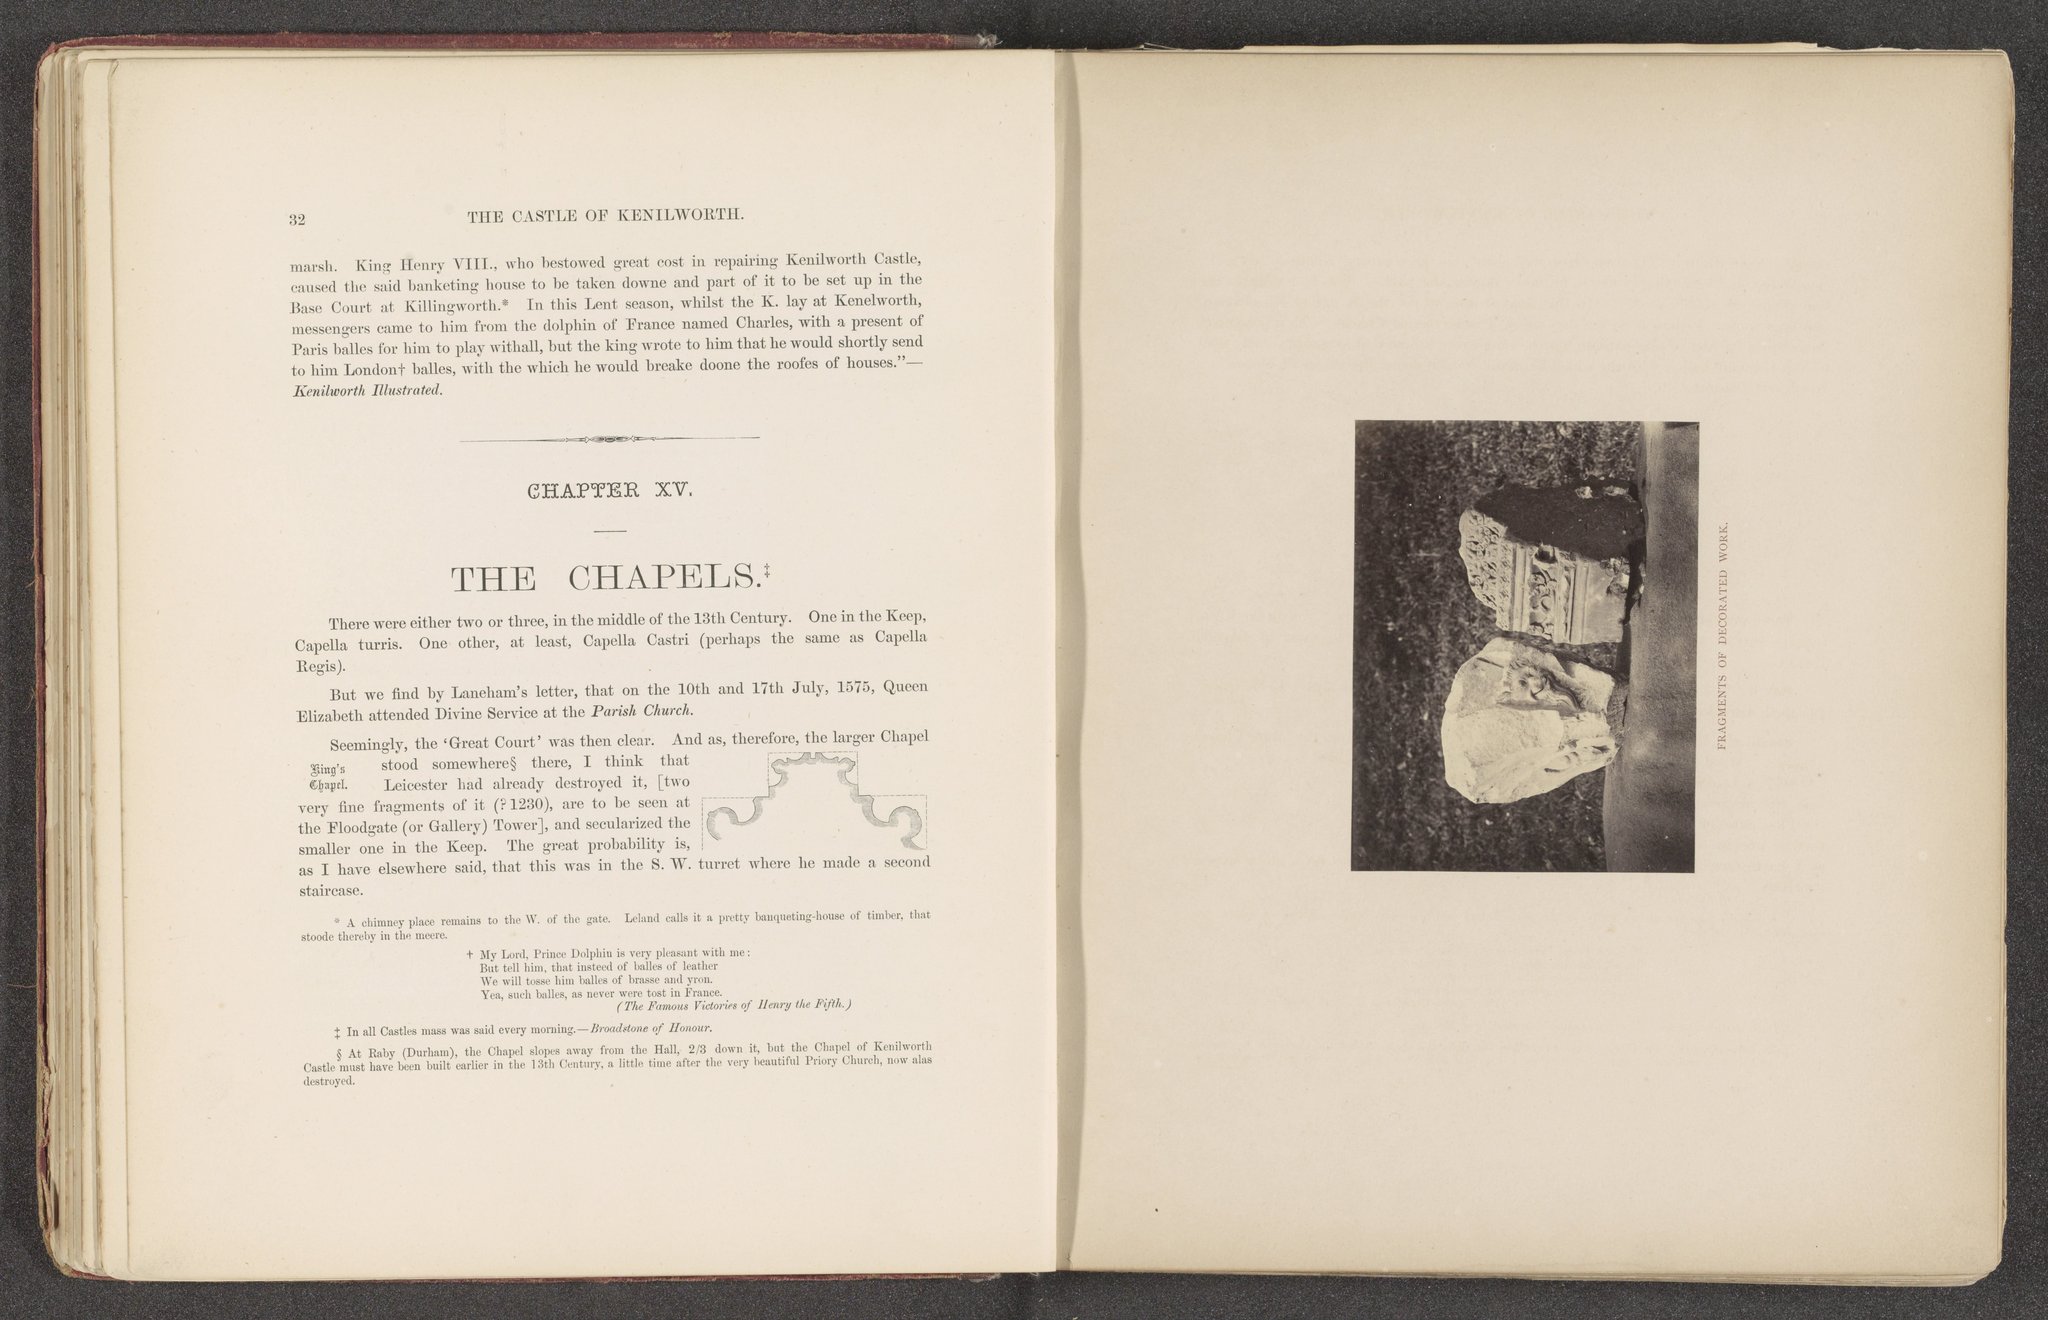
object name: page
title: Fragments of decorated work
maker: Anonymous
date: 1862-1872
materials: photographic support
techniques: albumen print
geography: kenilworth castle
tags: ornament derived from architectural details